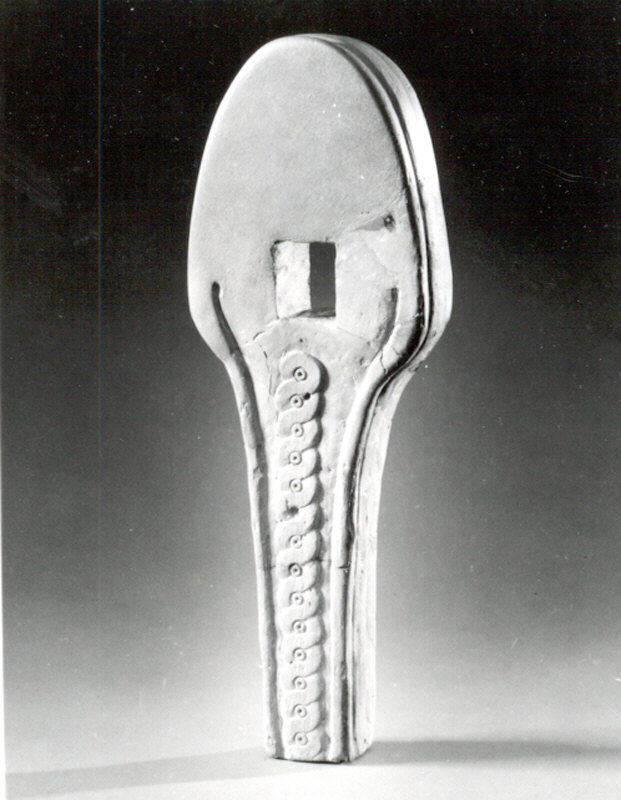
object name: handle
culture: iranian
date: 900-801 BCE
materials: glass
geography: iran